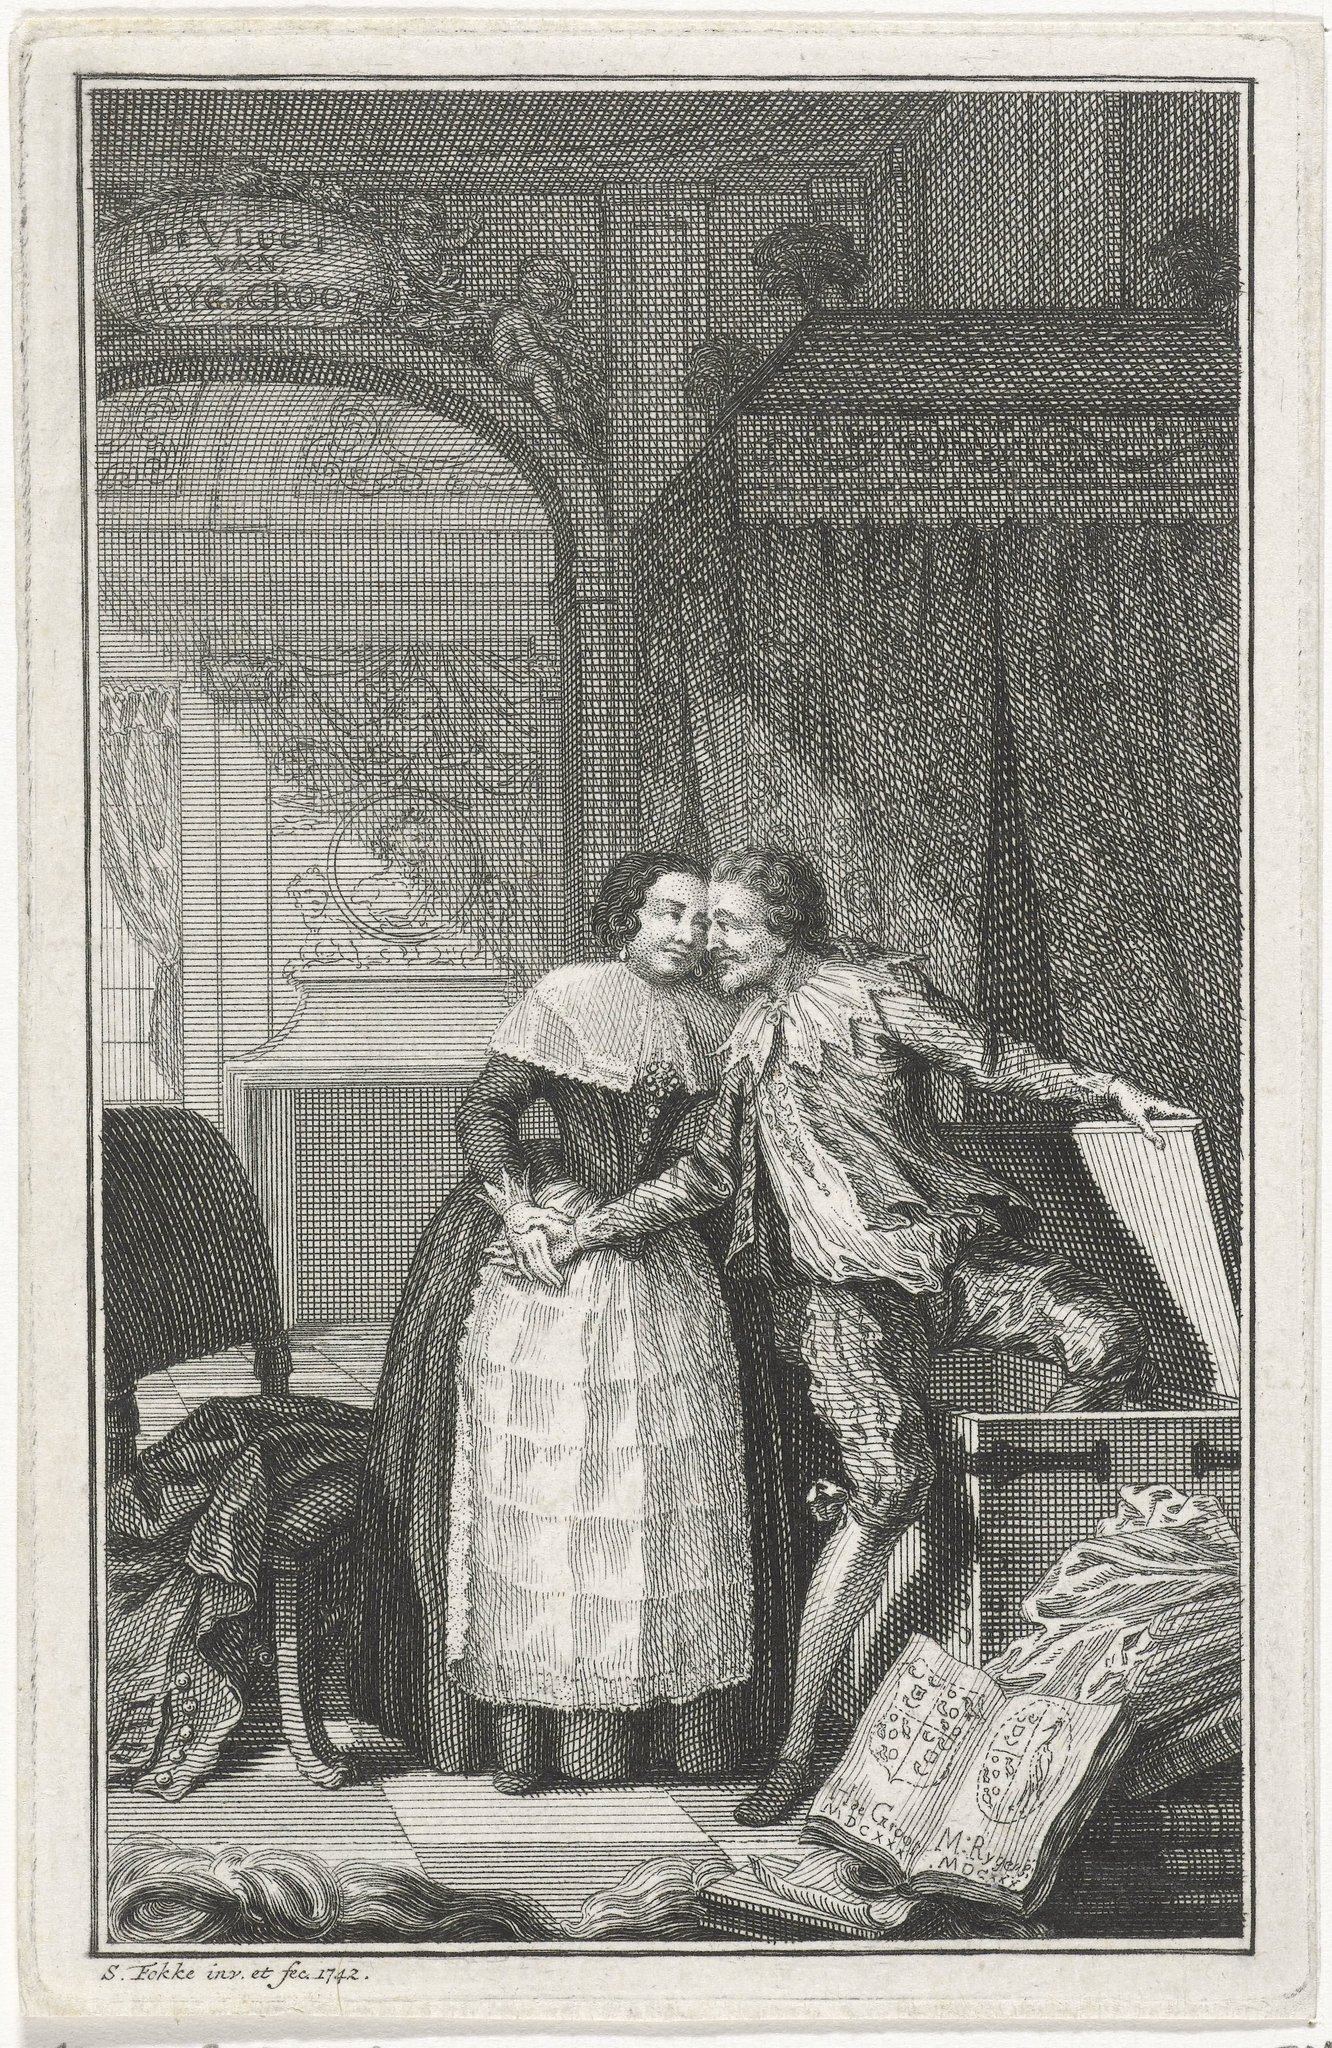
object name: print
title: De vlucht van Hugo de Groot uit slot Loevestein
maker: simon fokke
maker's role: draughtsman, print maker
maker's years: 1712-1784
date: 1742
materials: paper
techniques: engraving, etching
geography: amsterdam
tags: delft, hugo de groot, law and jurisprudence (+ escape from prison), loevestein castle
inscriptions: collector's mark: Lugt 240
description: Hugo de Groot stapt in een boekenkist en neemt afscheid van zijn echtgenote Maria van Reigersberch, die het plan voor de ontsnapping met de boekenkist had bedacht. Boven de doorgang naar een volgend vertrek staat de tekst: De Vlugt van Huyg de Groot. Deze prent is vervaardigd voor het gelijknamige blijspel van Frederik Duim (1742).